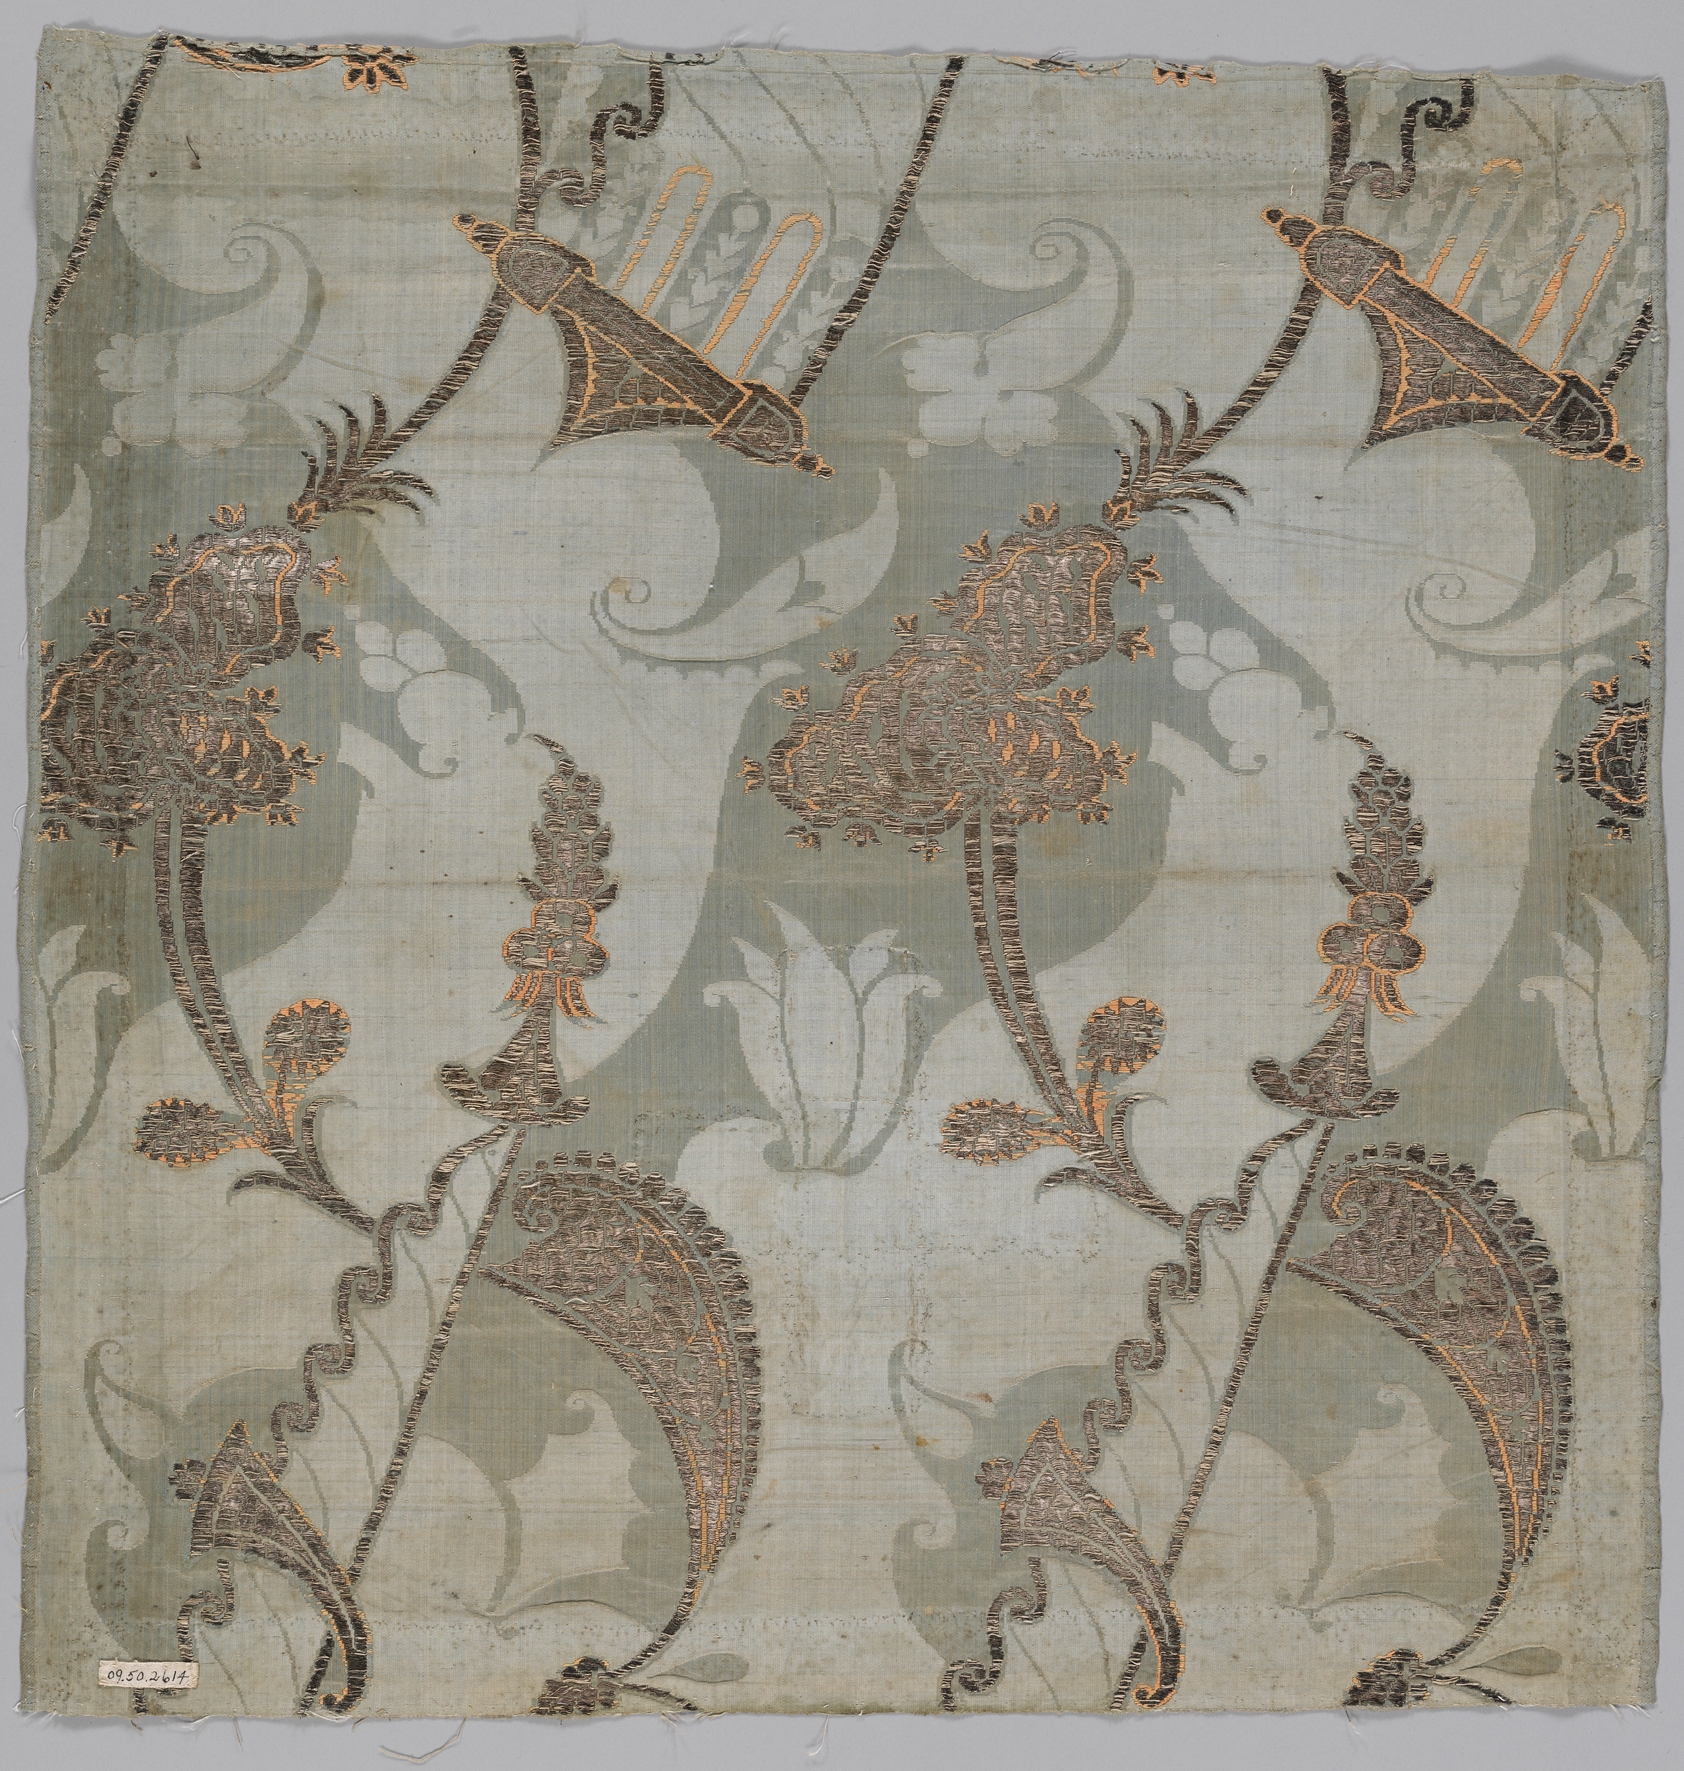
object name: piece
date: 1710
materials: metal thread, silk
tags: leaves